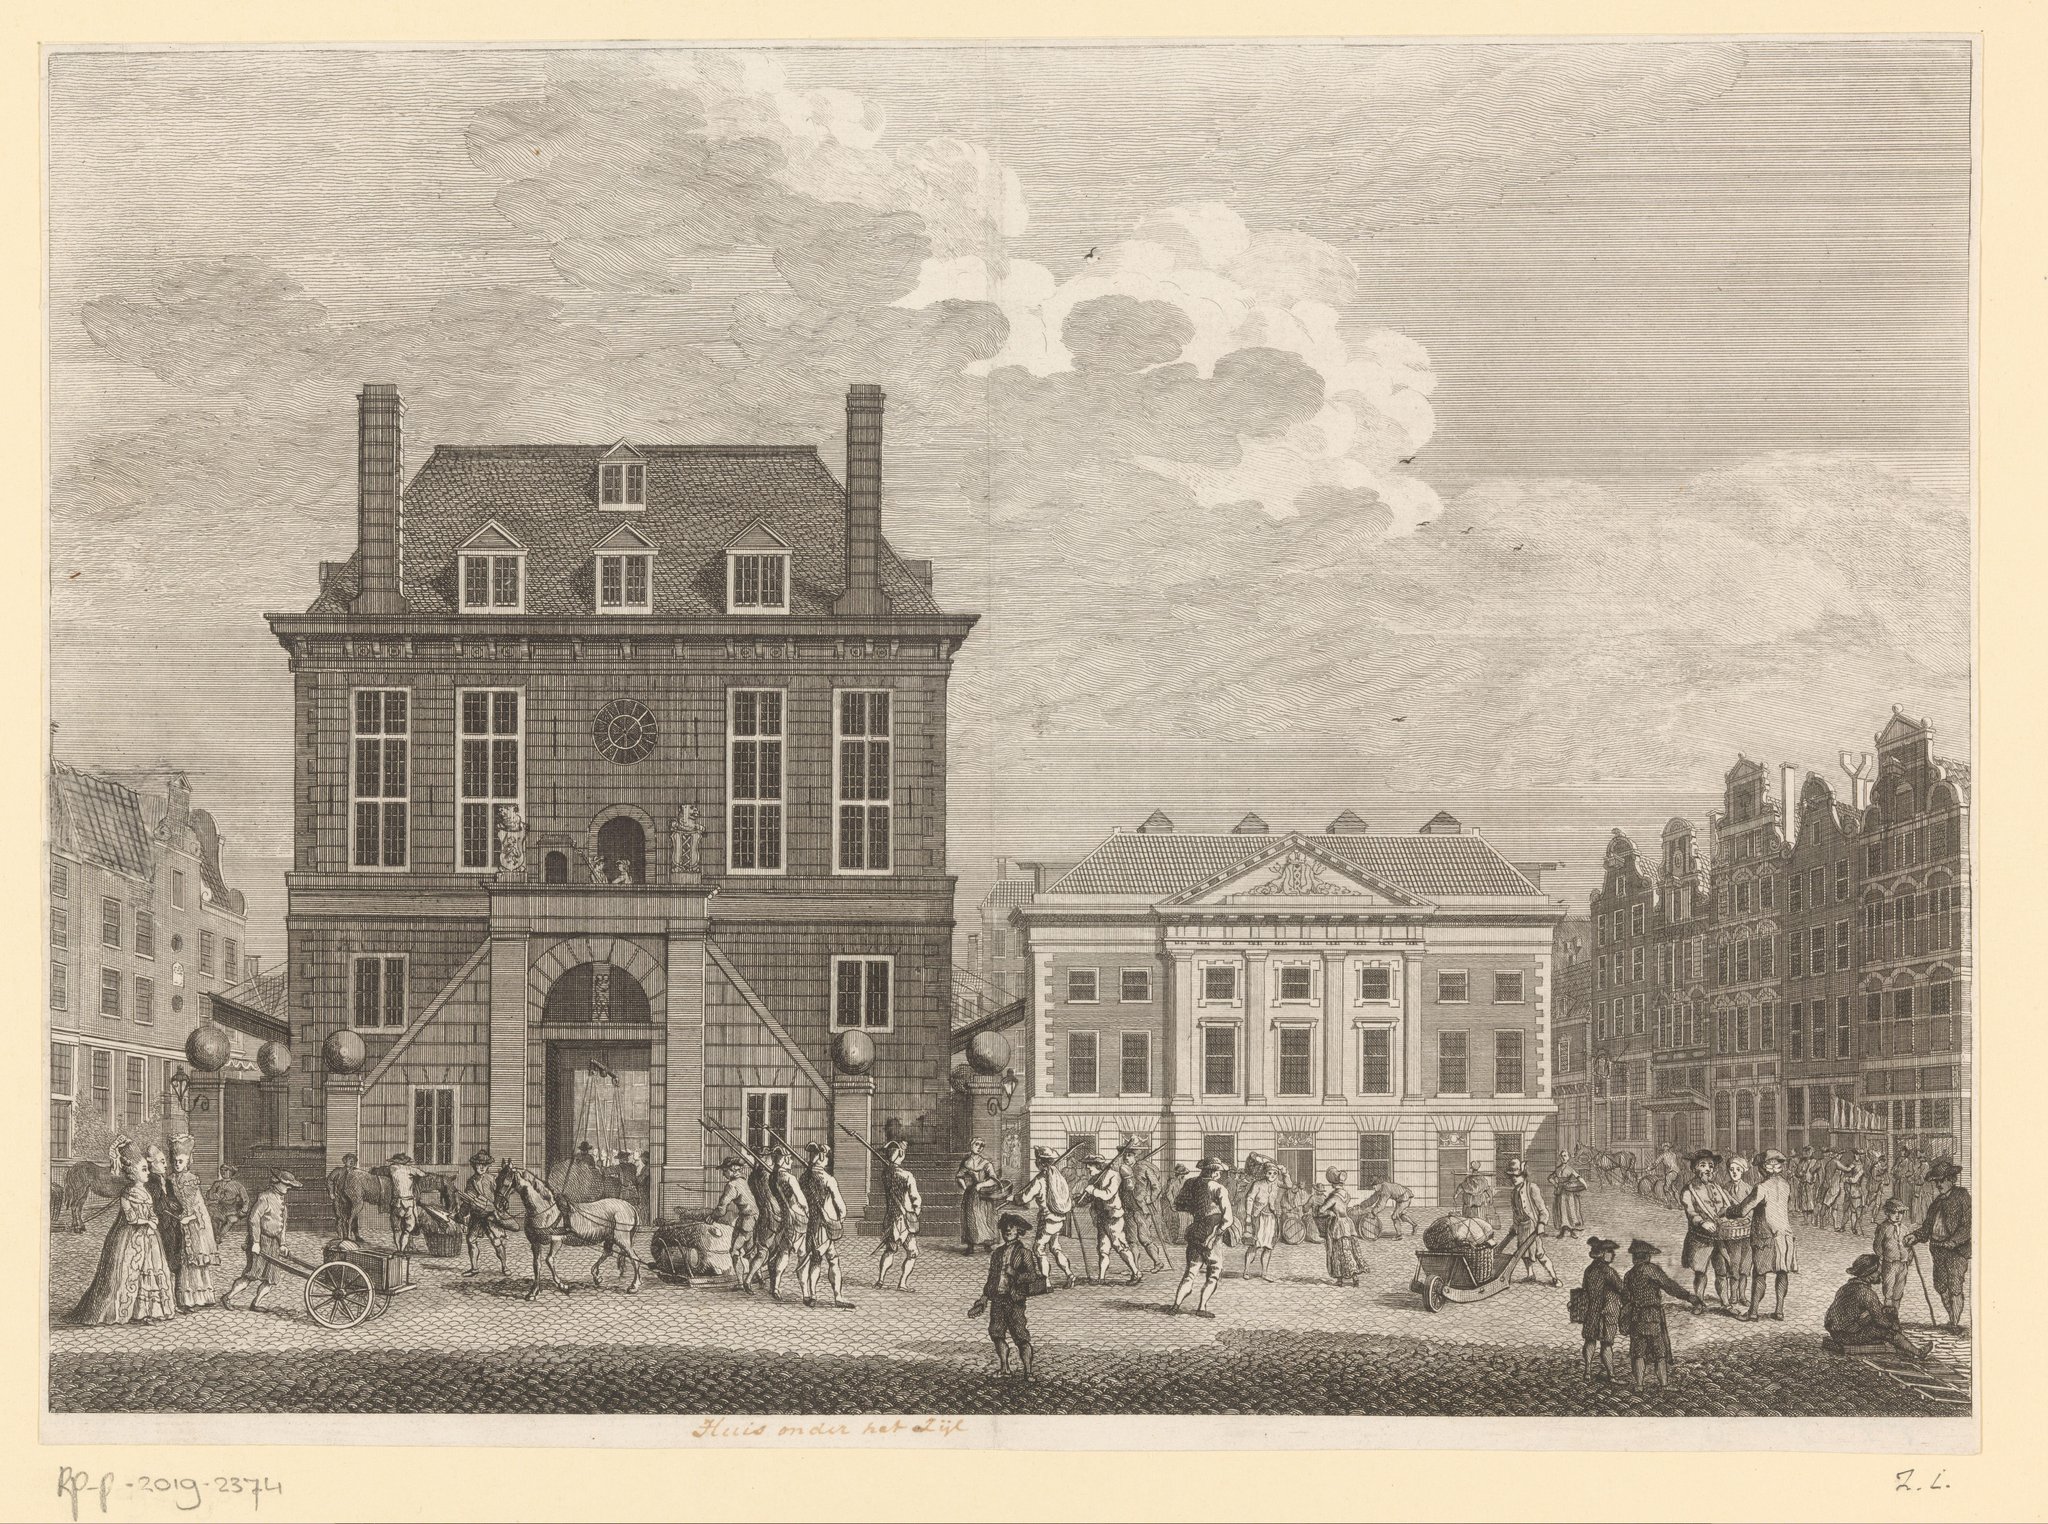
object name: print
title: Gezicht op de vernieuwde Waag op de Dam te Amsterdam, 1775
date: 1788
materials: paper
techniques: etching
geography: amsterdam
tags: weigh-house, square, place, circus, etc. (+ city(-scape) with figures, staffage)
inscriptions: inscription: ‘Huis onder het Zijl’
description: Prent uit een heruitgave van de Atlas van Fouquet: Stijl, Simon. Amsterdam, in zyne geschiedenissen, voorregten, koophandel, gebouwen, kerkenstaat, schoolen, schutterye, gilden en regeeringe, beschreeven. Om te dienen ten vervolge op het werk van Jan Wagenaar (…). 10 dln. Amsterdam en Harlingen: Petrus Conradi en Folkert van der Plaats, 1788, dl. 1.